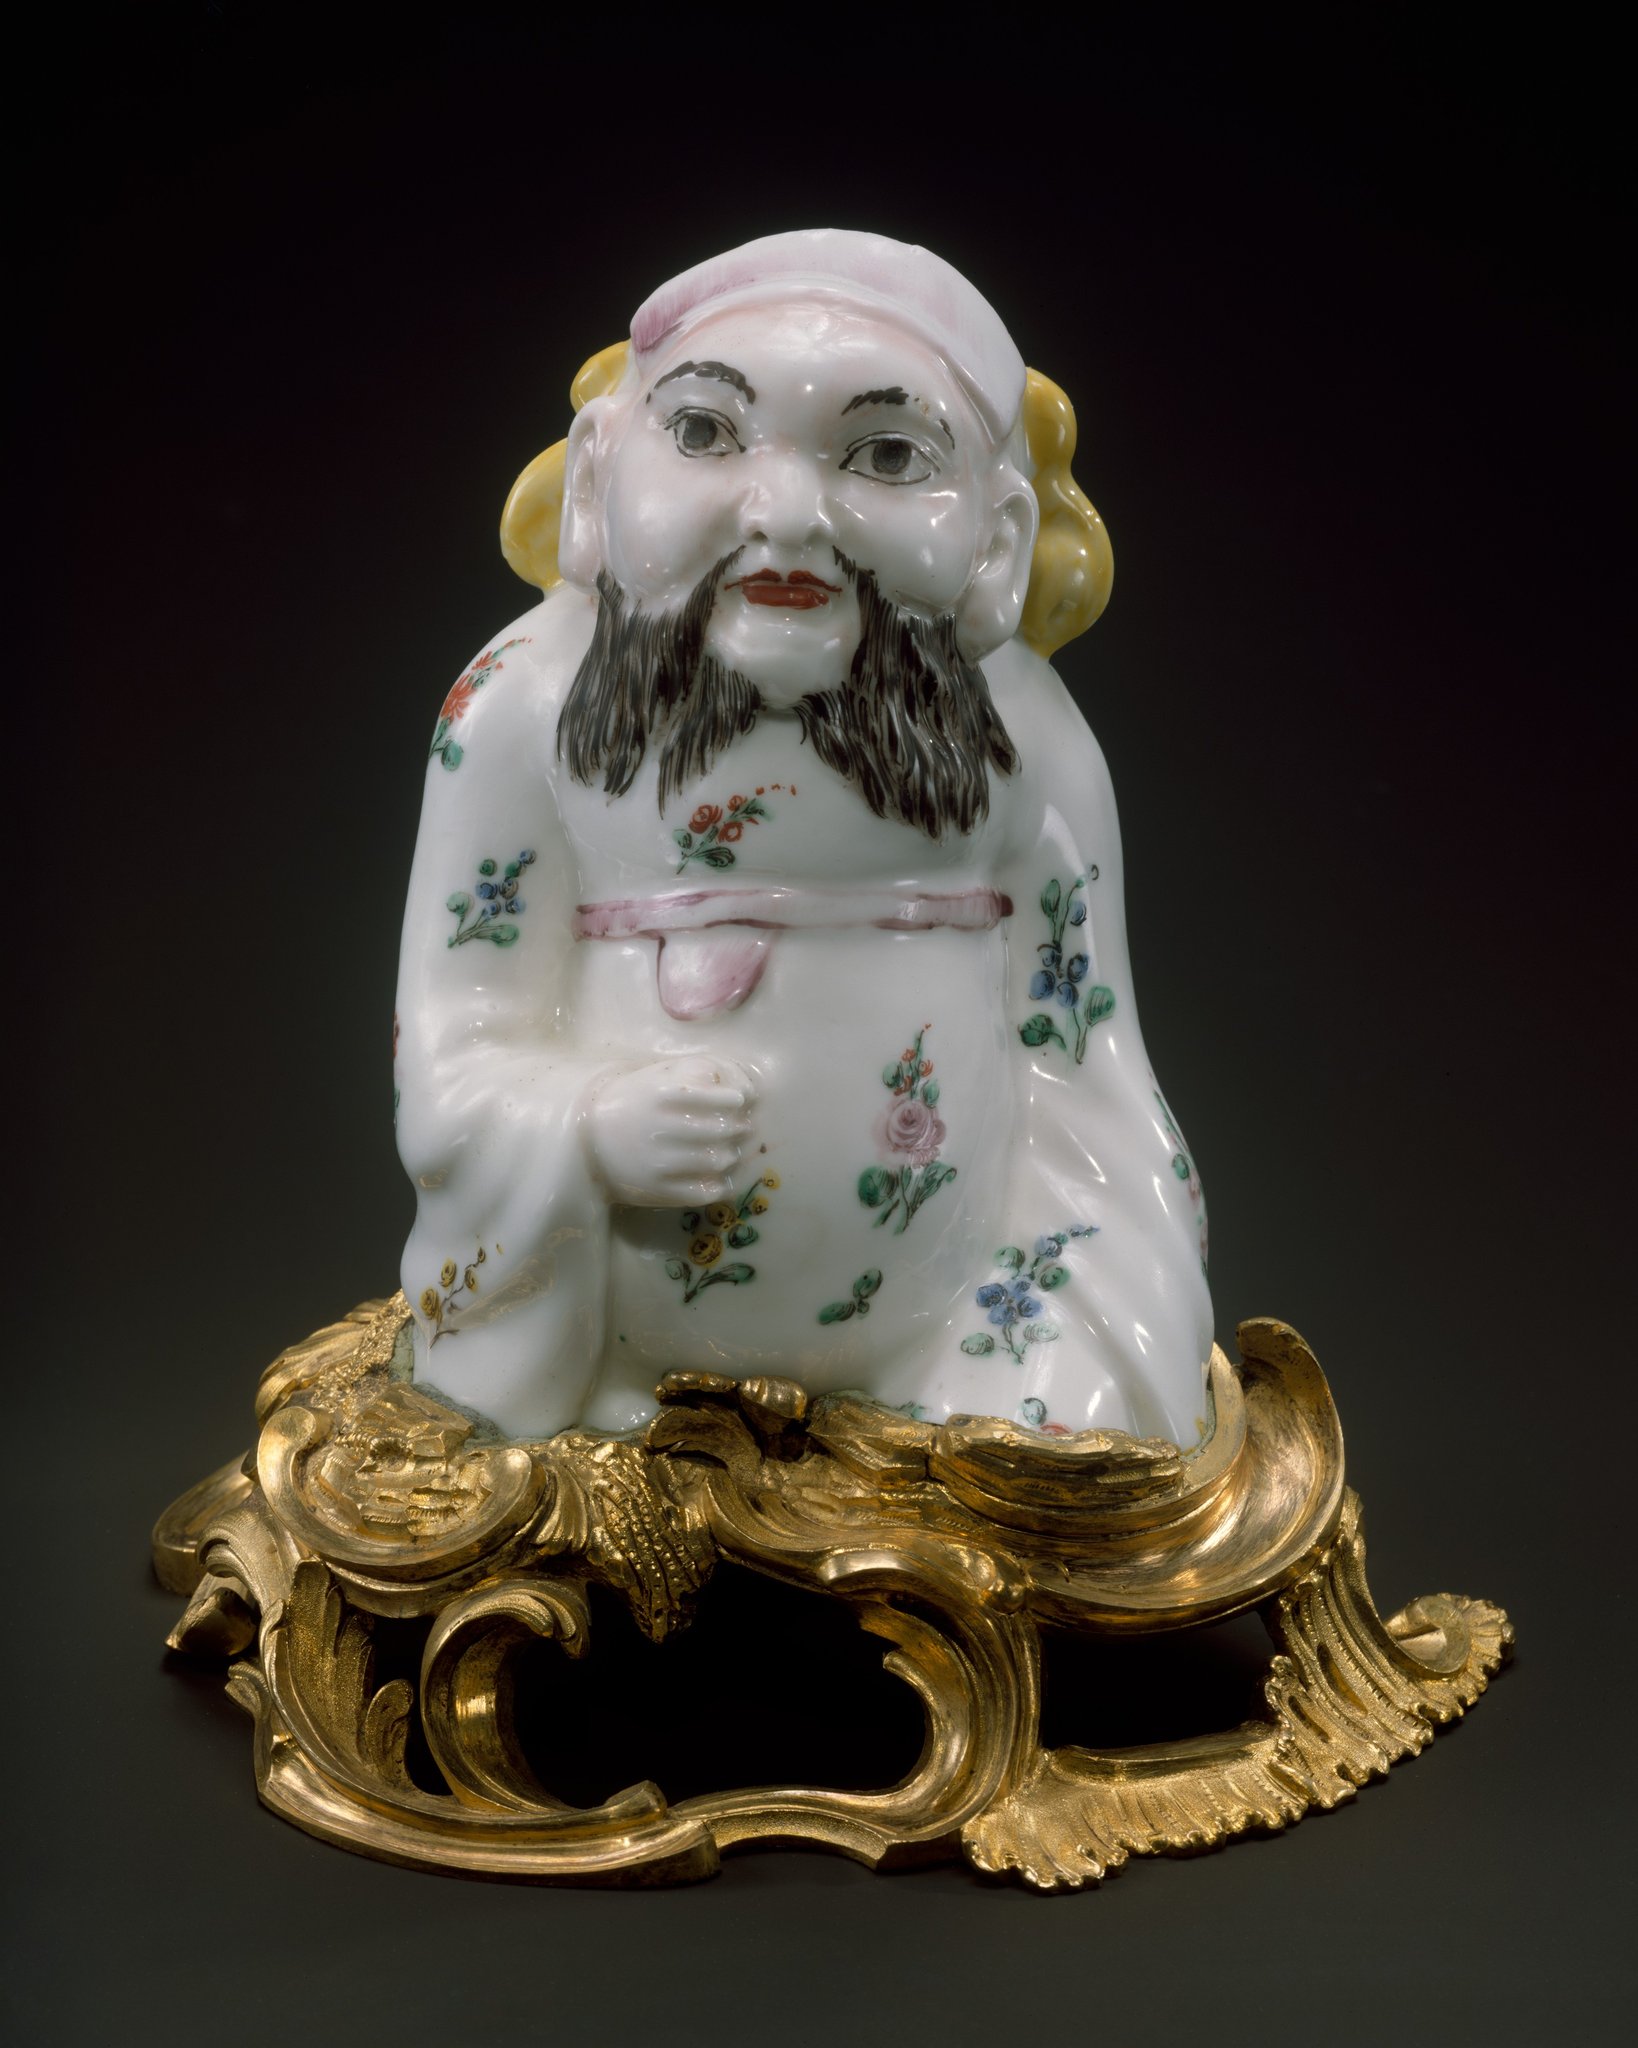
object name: figure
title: Figure of a seated Chinese man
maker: mennecy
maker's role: factory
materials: gilt bronze, soft paste porcelain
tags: men